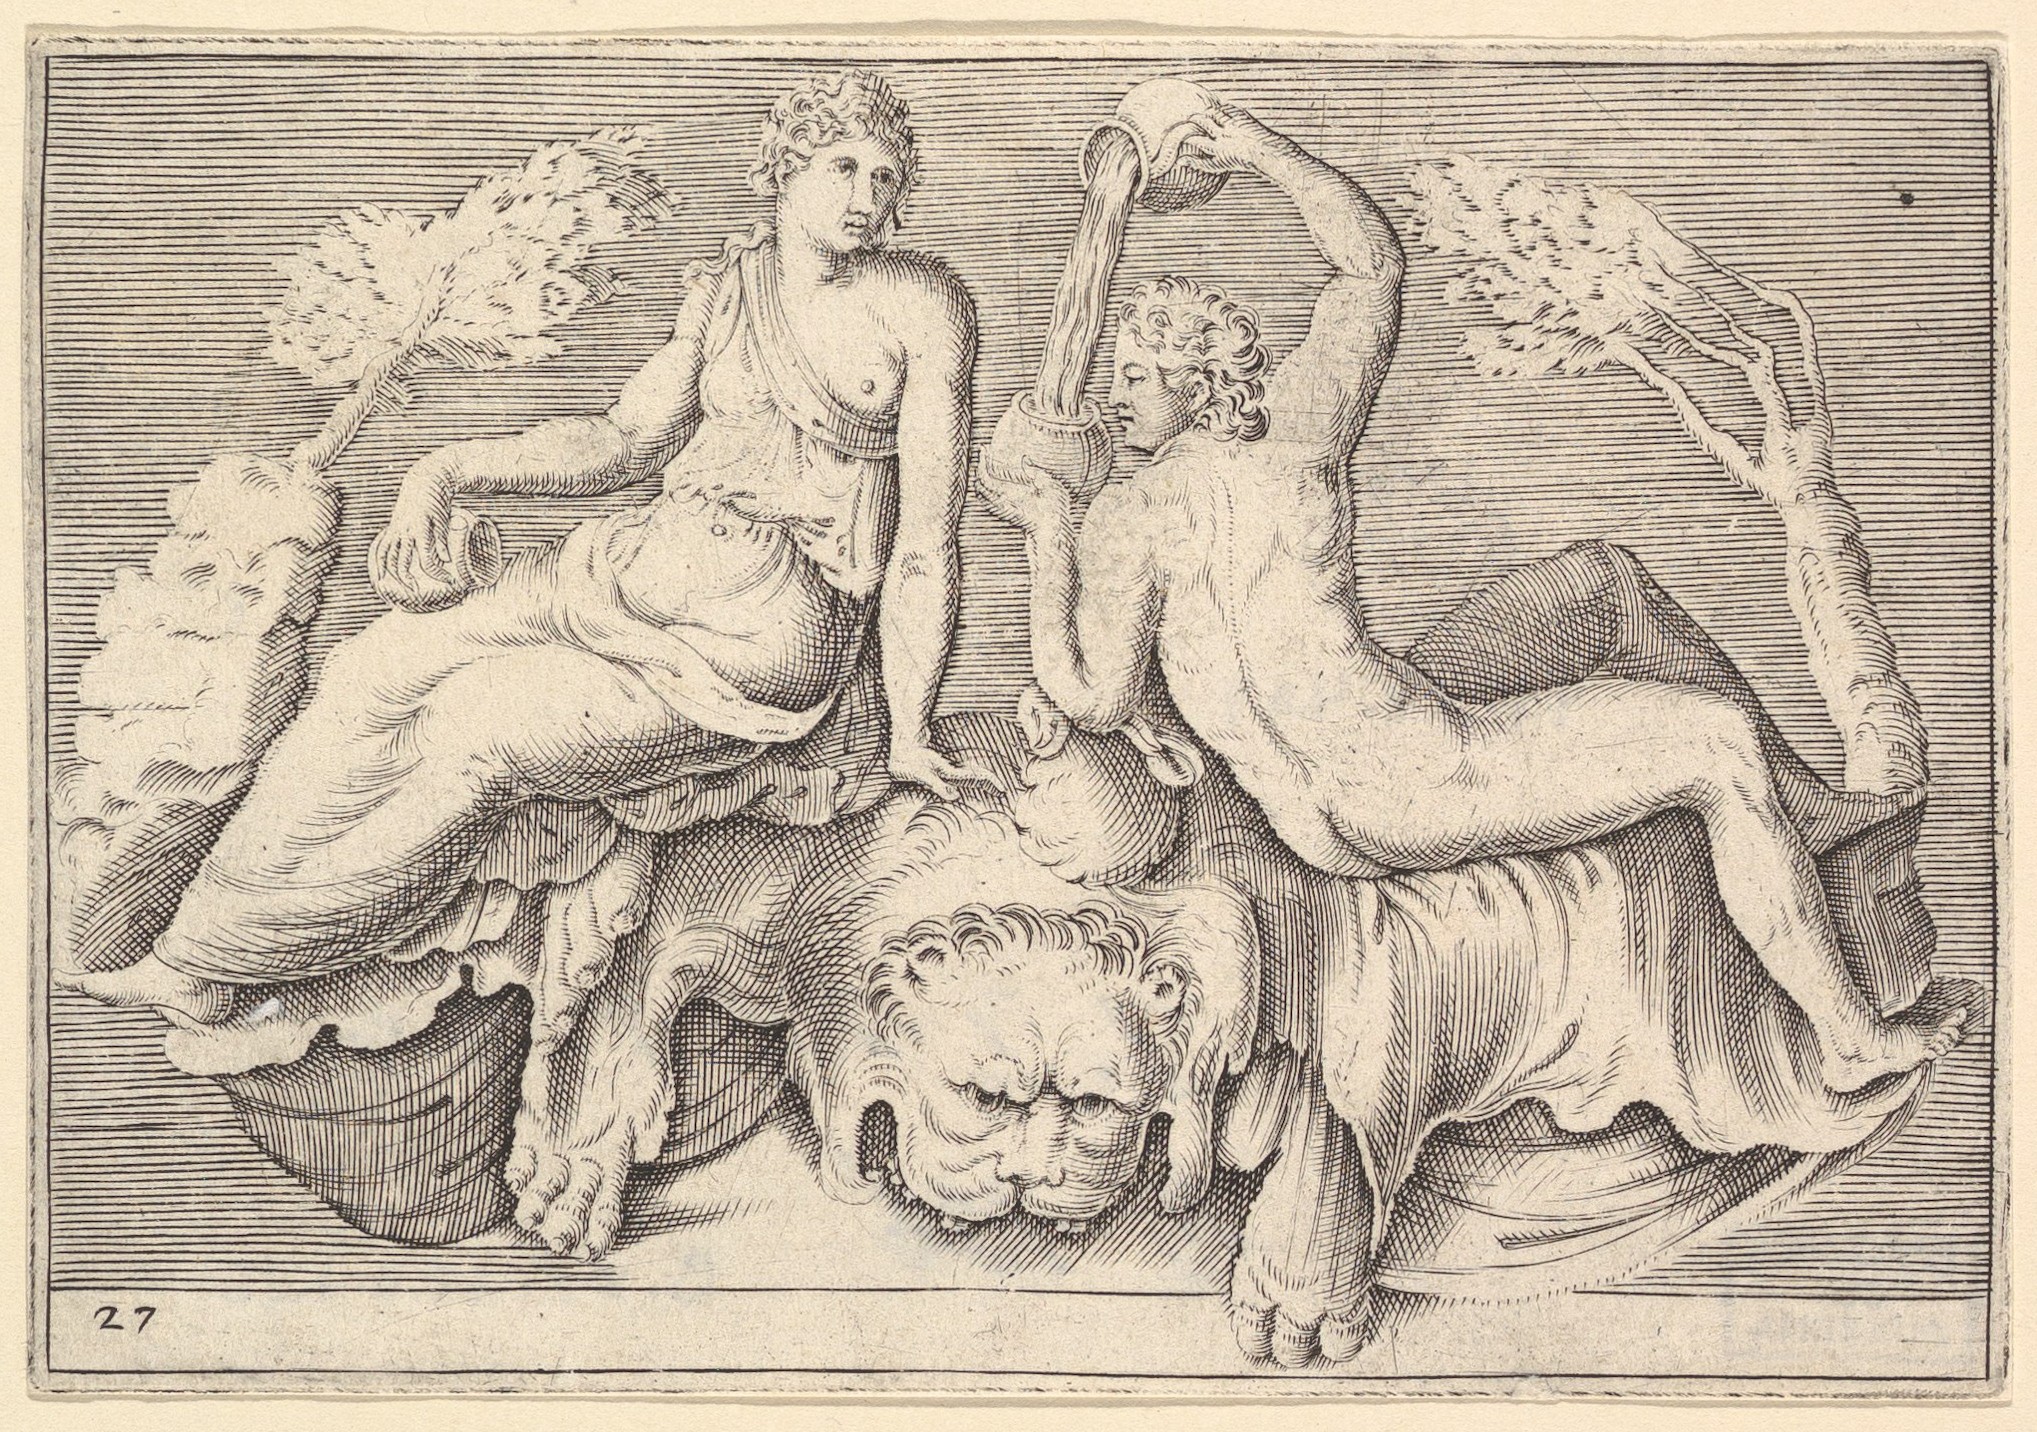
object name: print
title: Woman and Man Seated on Lionskin, Man Pouring Wine, from "Ex Antiquis Cameorum et Gemmae Delineata/ Liber Secundus/et ab Enea Vico Parmen Incis"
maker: anonymous, italian, 16th century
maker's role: artist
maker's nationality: italian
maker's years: 1500-1600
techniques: engraving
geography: rome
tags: wine,men,women,lions